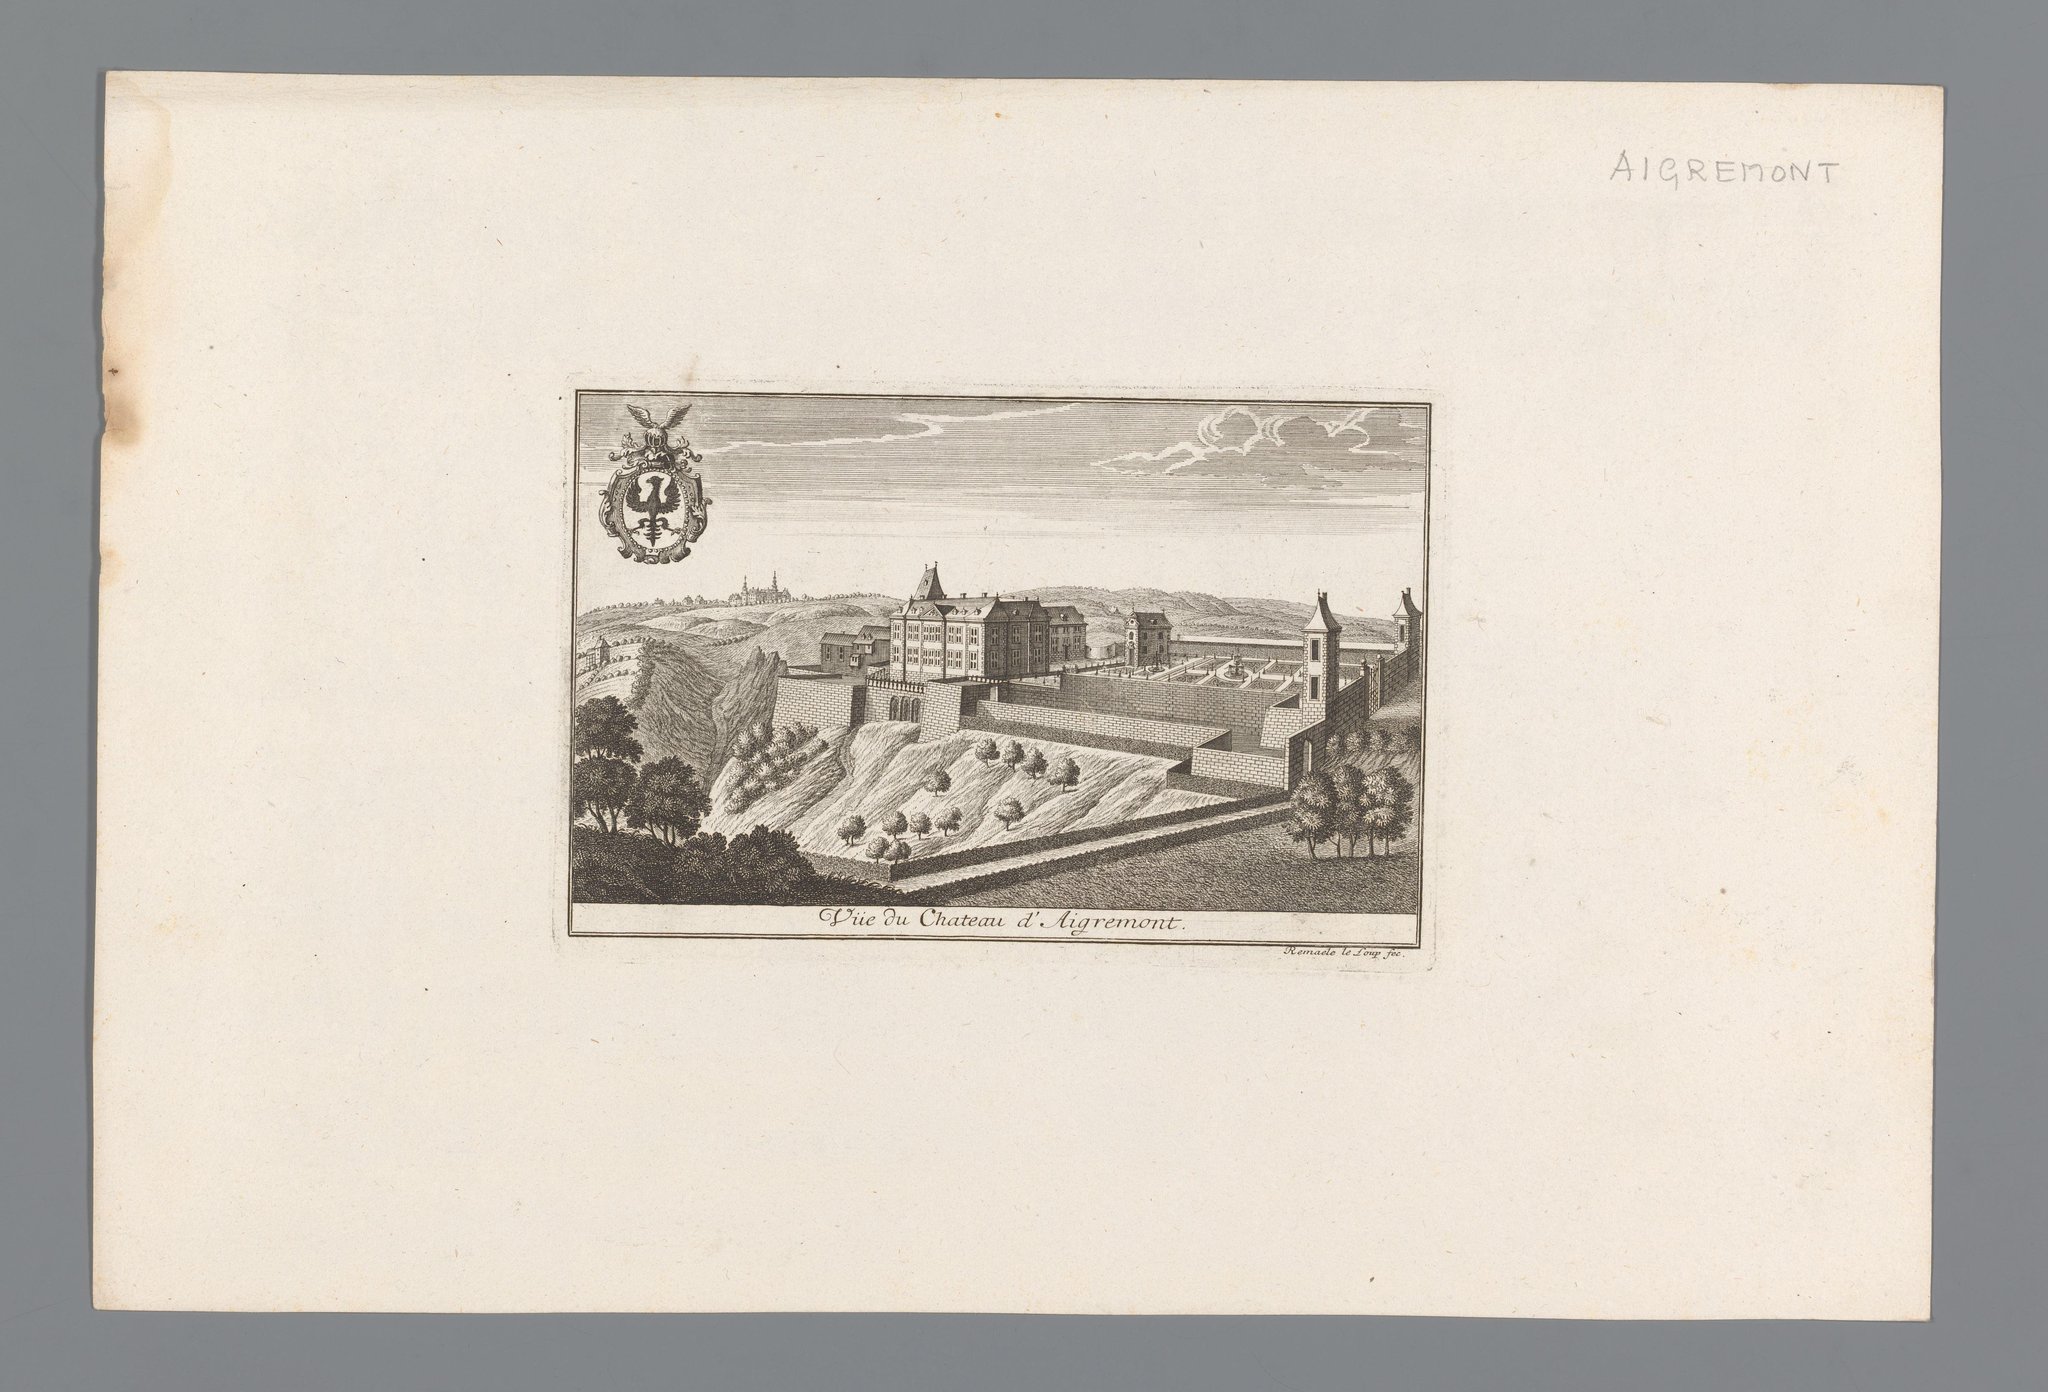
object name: print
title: Vuë du Chateau d'Aigremont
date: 1738-1744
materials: paper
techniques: etching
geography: liège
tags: castle, landscape with tower or castle, liège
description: Prent uit: Johanne de Saumery, Alexandre de et al. Les délices du paîs de Liège, ou description géographique, topographique et chorographique des monumes sacrés et profanes (...). 5 dln. Luik: Everard Kints, 1738-1744.